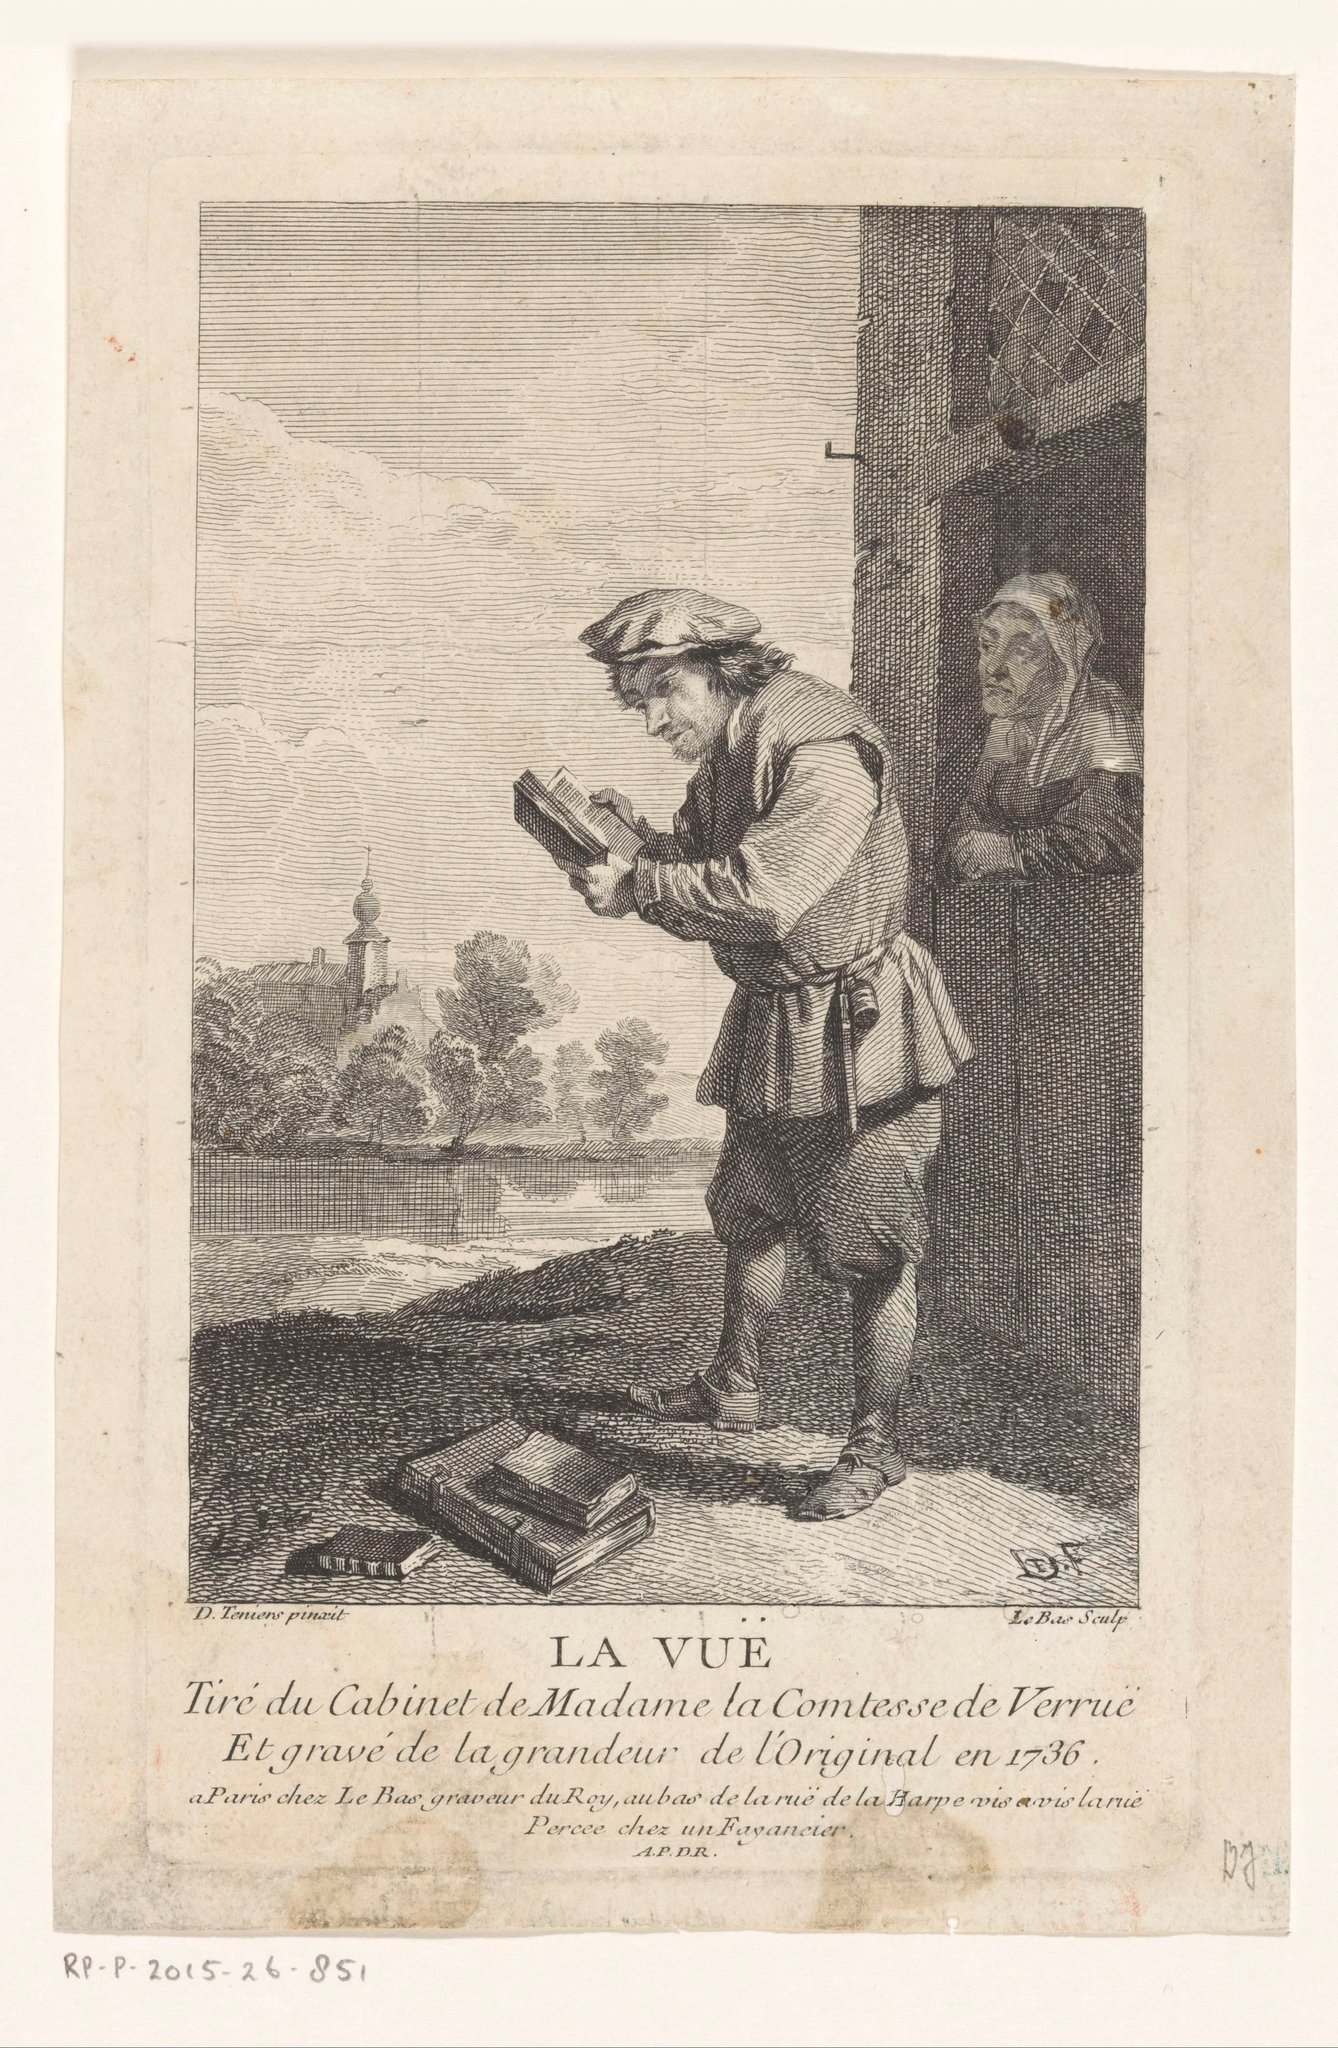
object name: print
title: Vijf zintuigen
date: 1736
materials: paper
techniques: etching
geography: paris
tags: sight, looking (one of the five senses), book, newspaper, news-sheet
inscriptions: collector's mark: Lugt 2228, number: ‘No. 6’, collector's mark: Lugt 4779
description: Achter de man staat een vrouw in de deuropening. In de achtergrond riviergezicht met een toren.